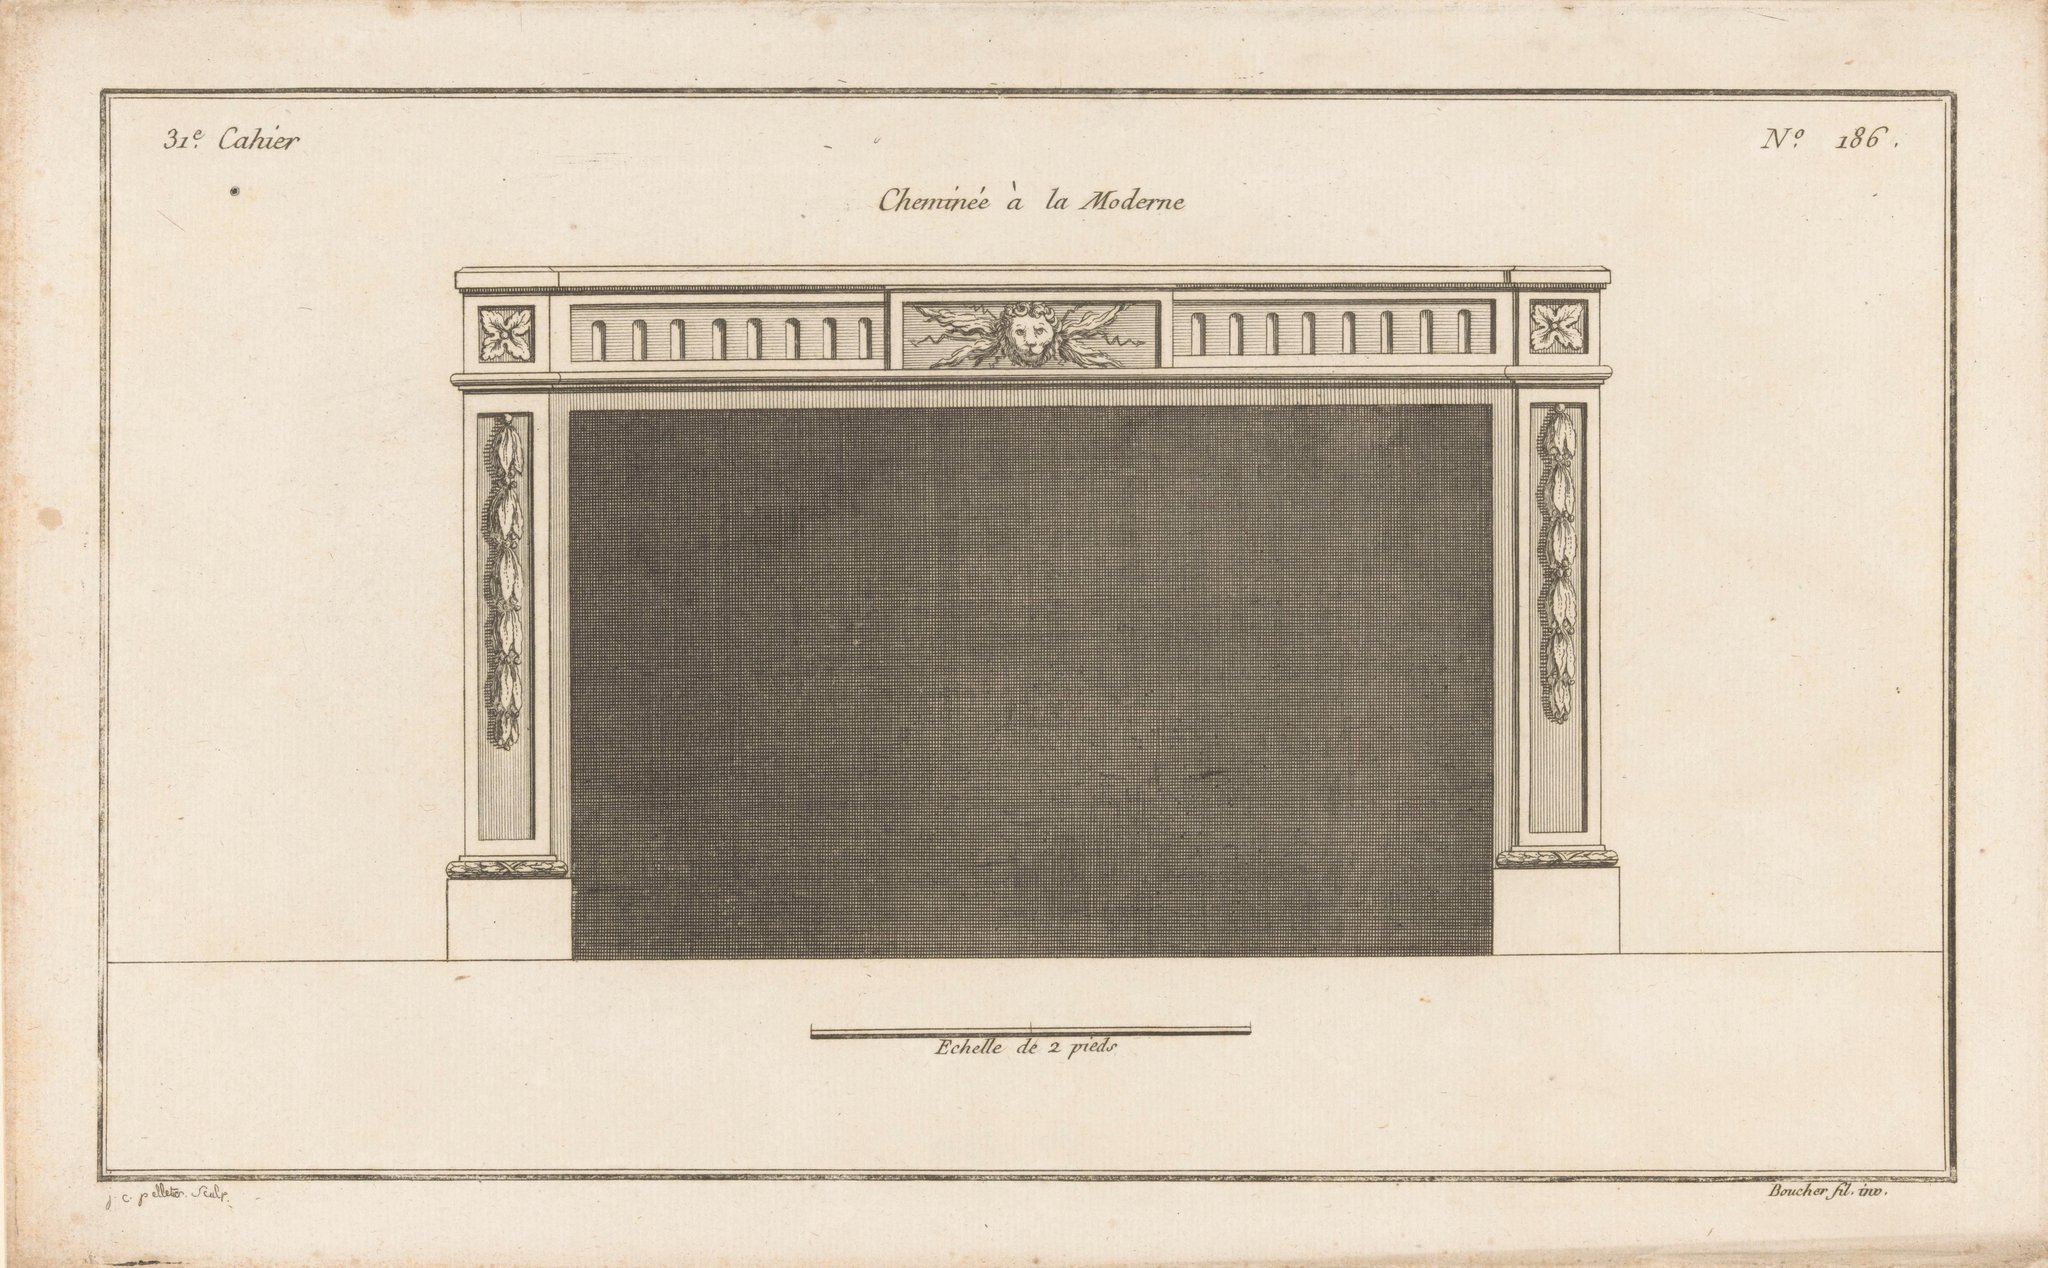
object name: print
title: Cheminée à la Moderne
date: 1772-1779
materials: paper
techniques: engraving, etching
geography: paris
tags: lion's head ~ ornament, foliage ~ ornament, open hearth, fire-place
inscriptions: collector's mark: Lugt 2760, collector's mark: Lugt 2228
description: Een open haard gedecoreerd met bladmotieven en een leeuwenkop omgeven door bliksemschichten. Prentnummer 186.